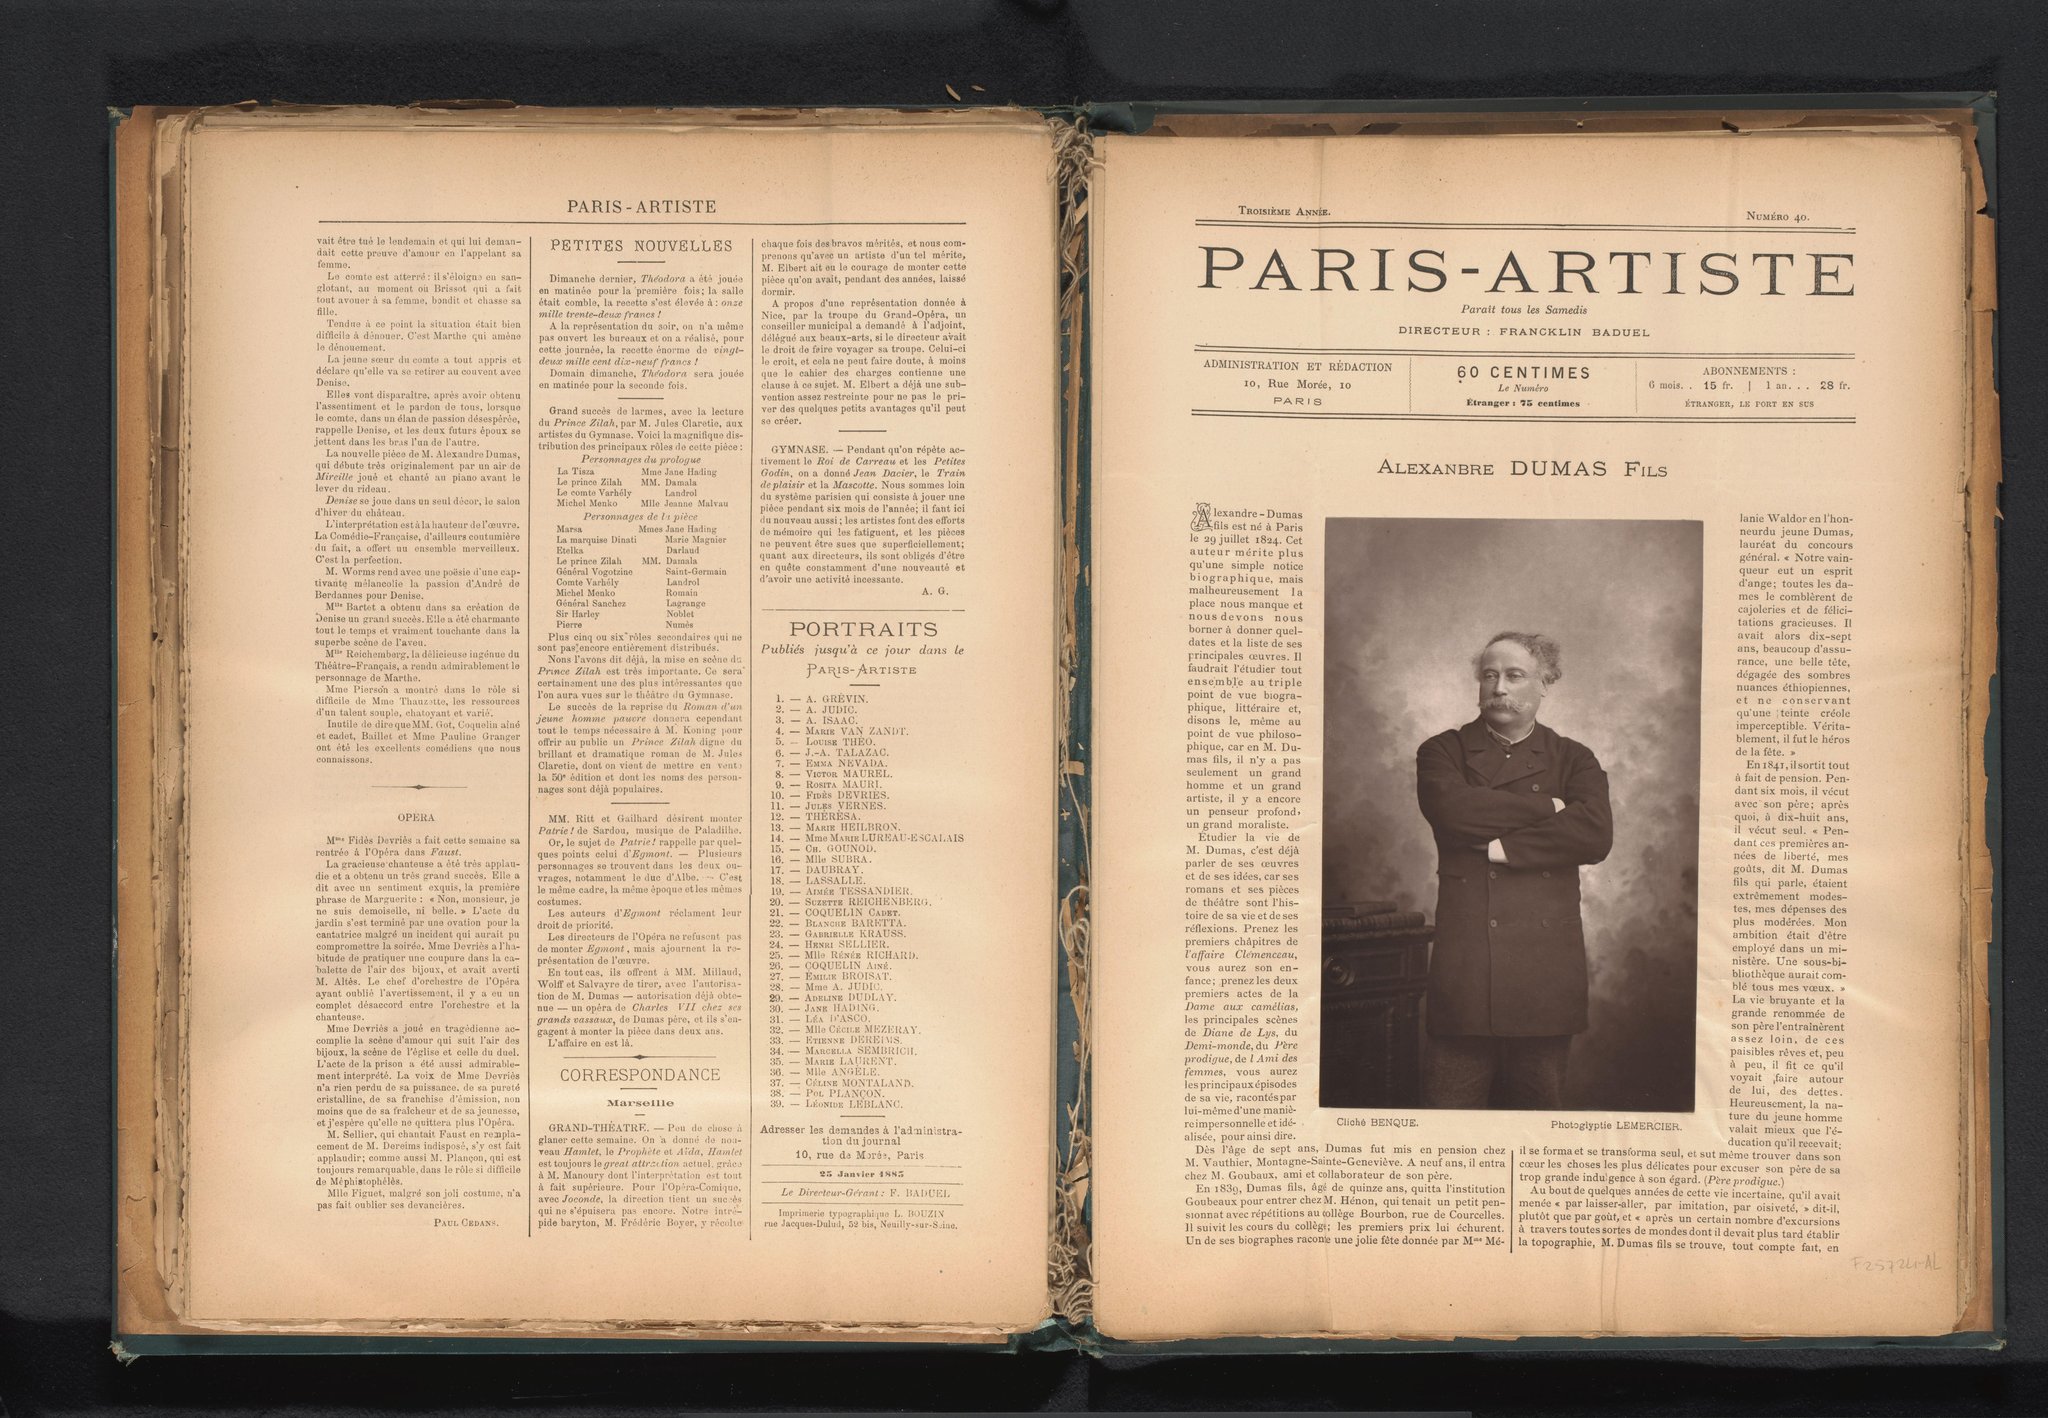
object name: page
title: Portret van Alexandre Dumas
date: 1875-1885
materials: paper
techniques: woodburytype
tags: paris, historical persons, writer, poet, author